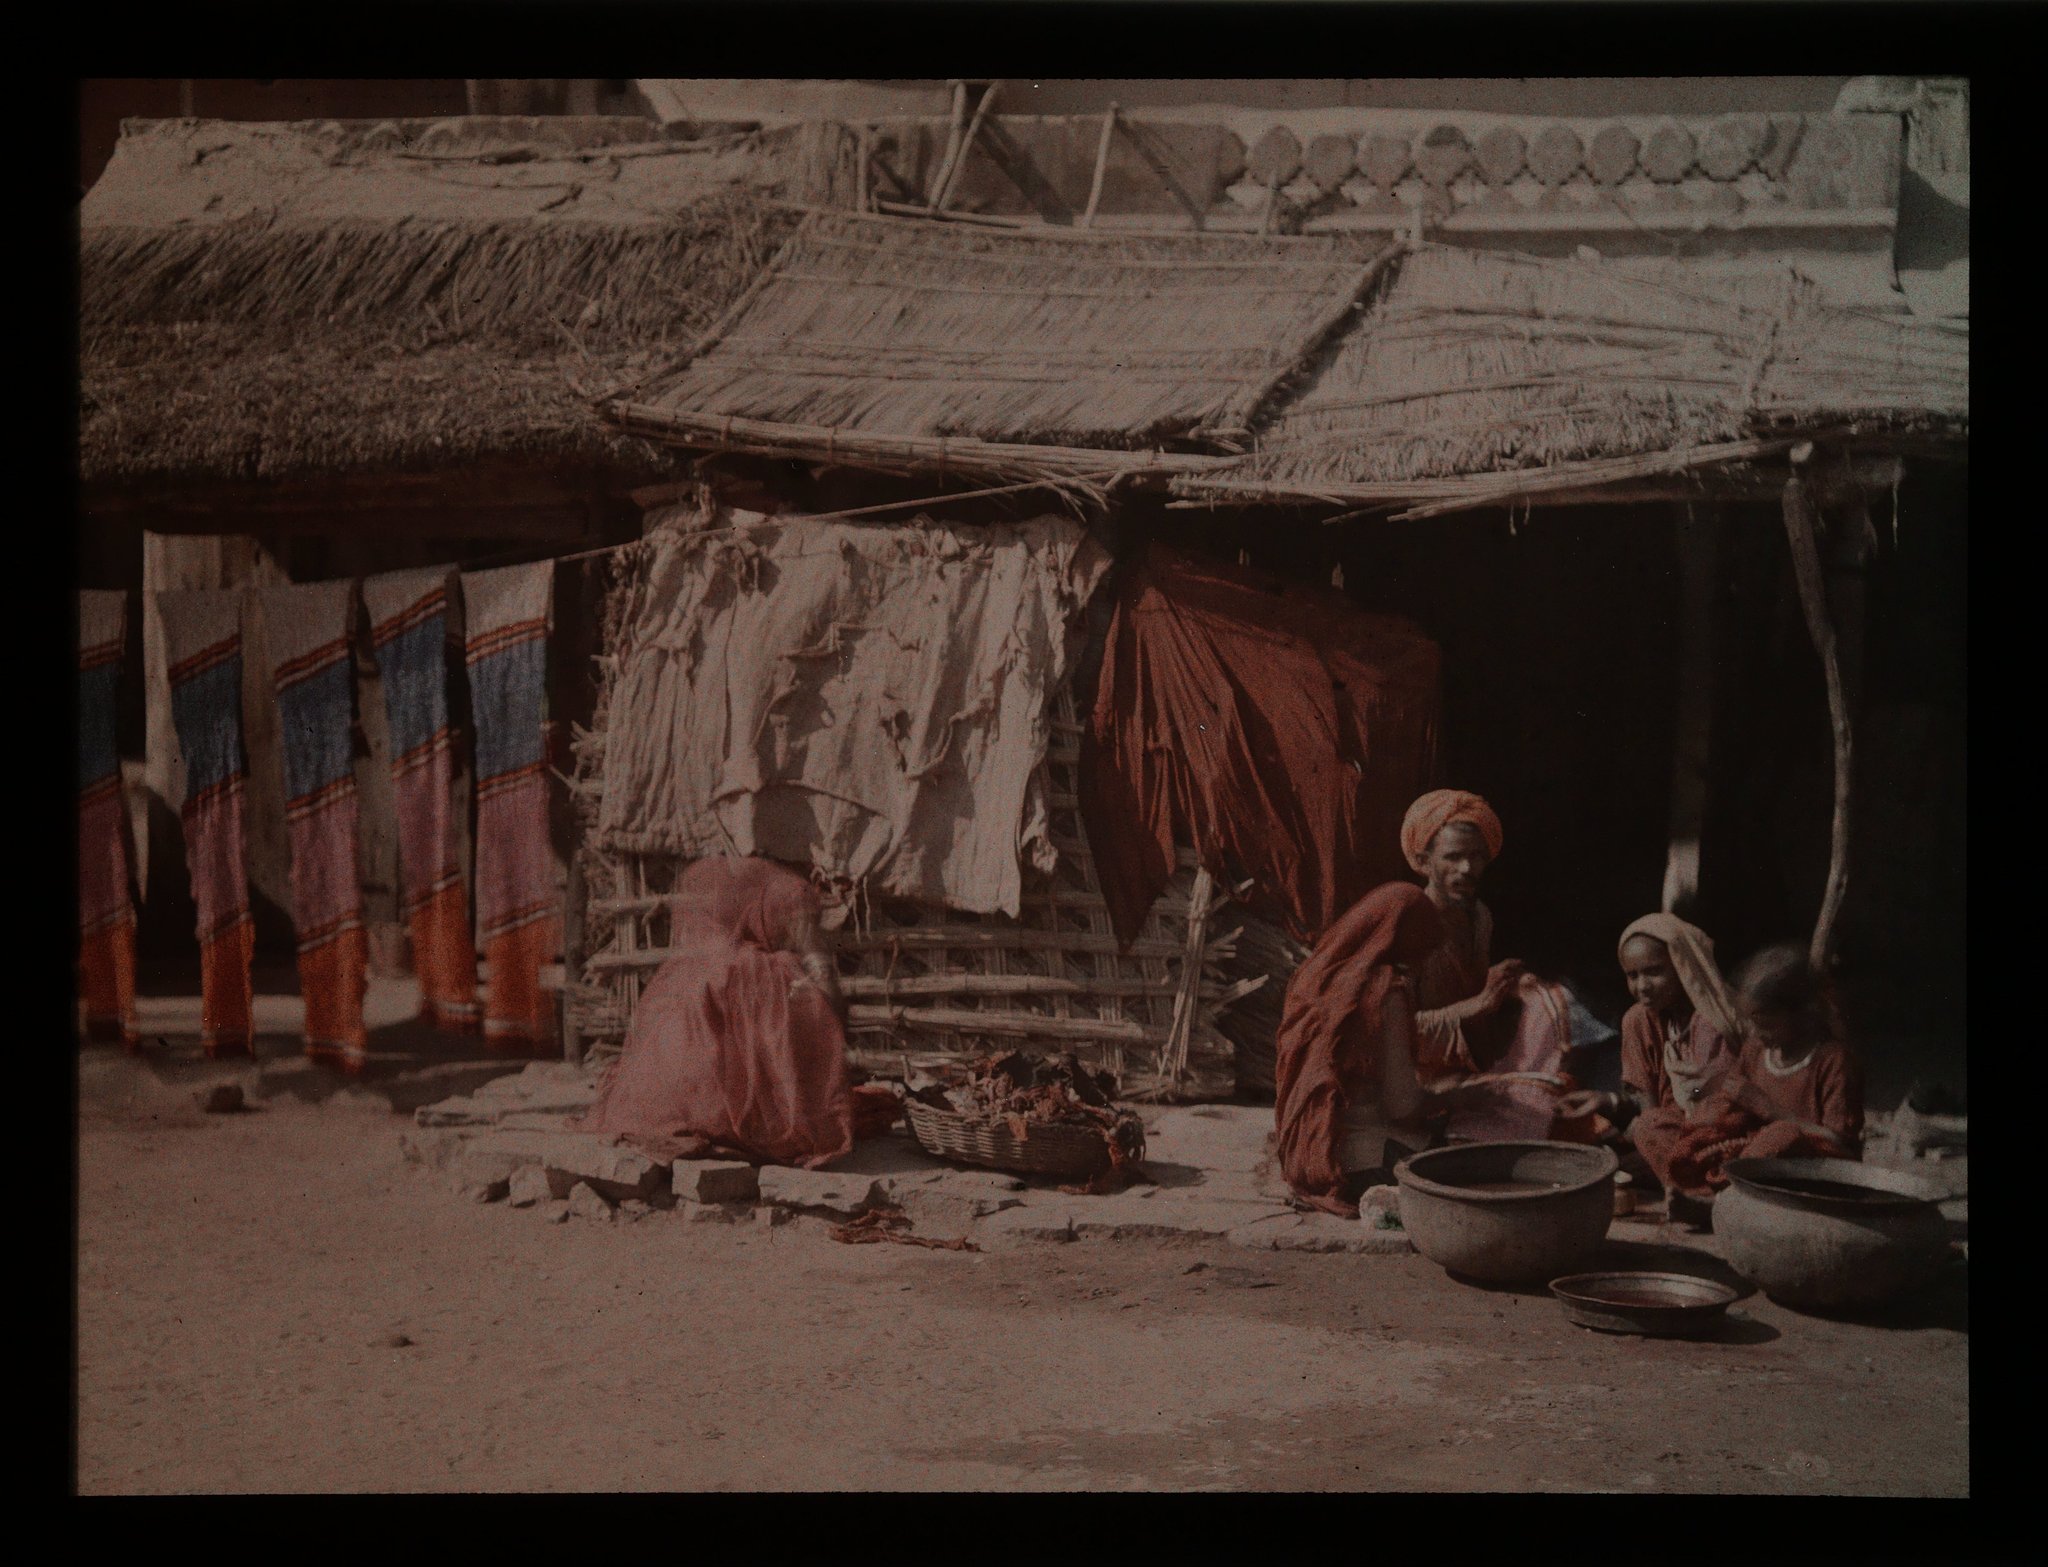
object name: photograph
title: Hut met bewoners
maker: Anonymous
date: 1910-1940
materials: glass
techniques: autochrome process